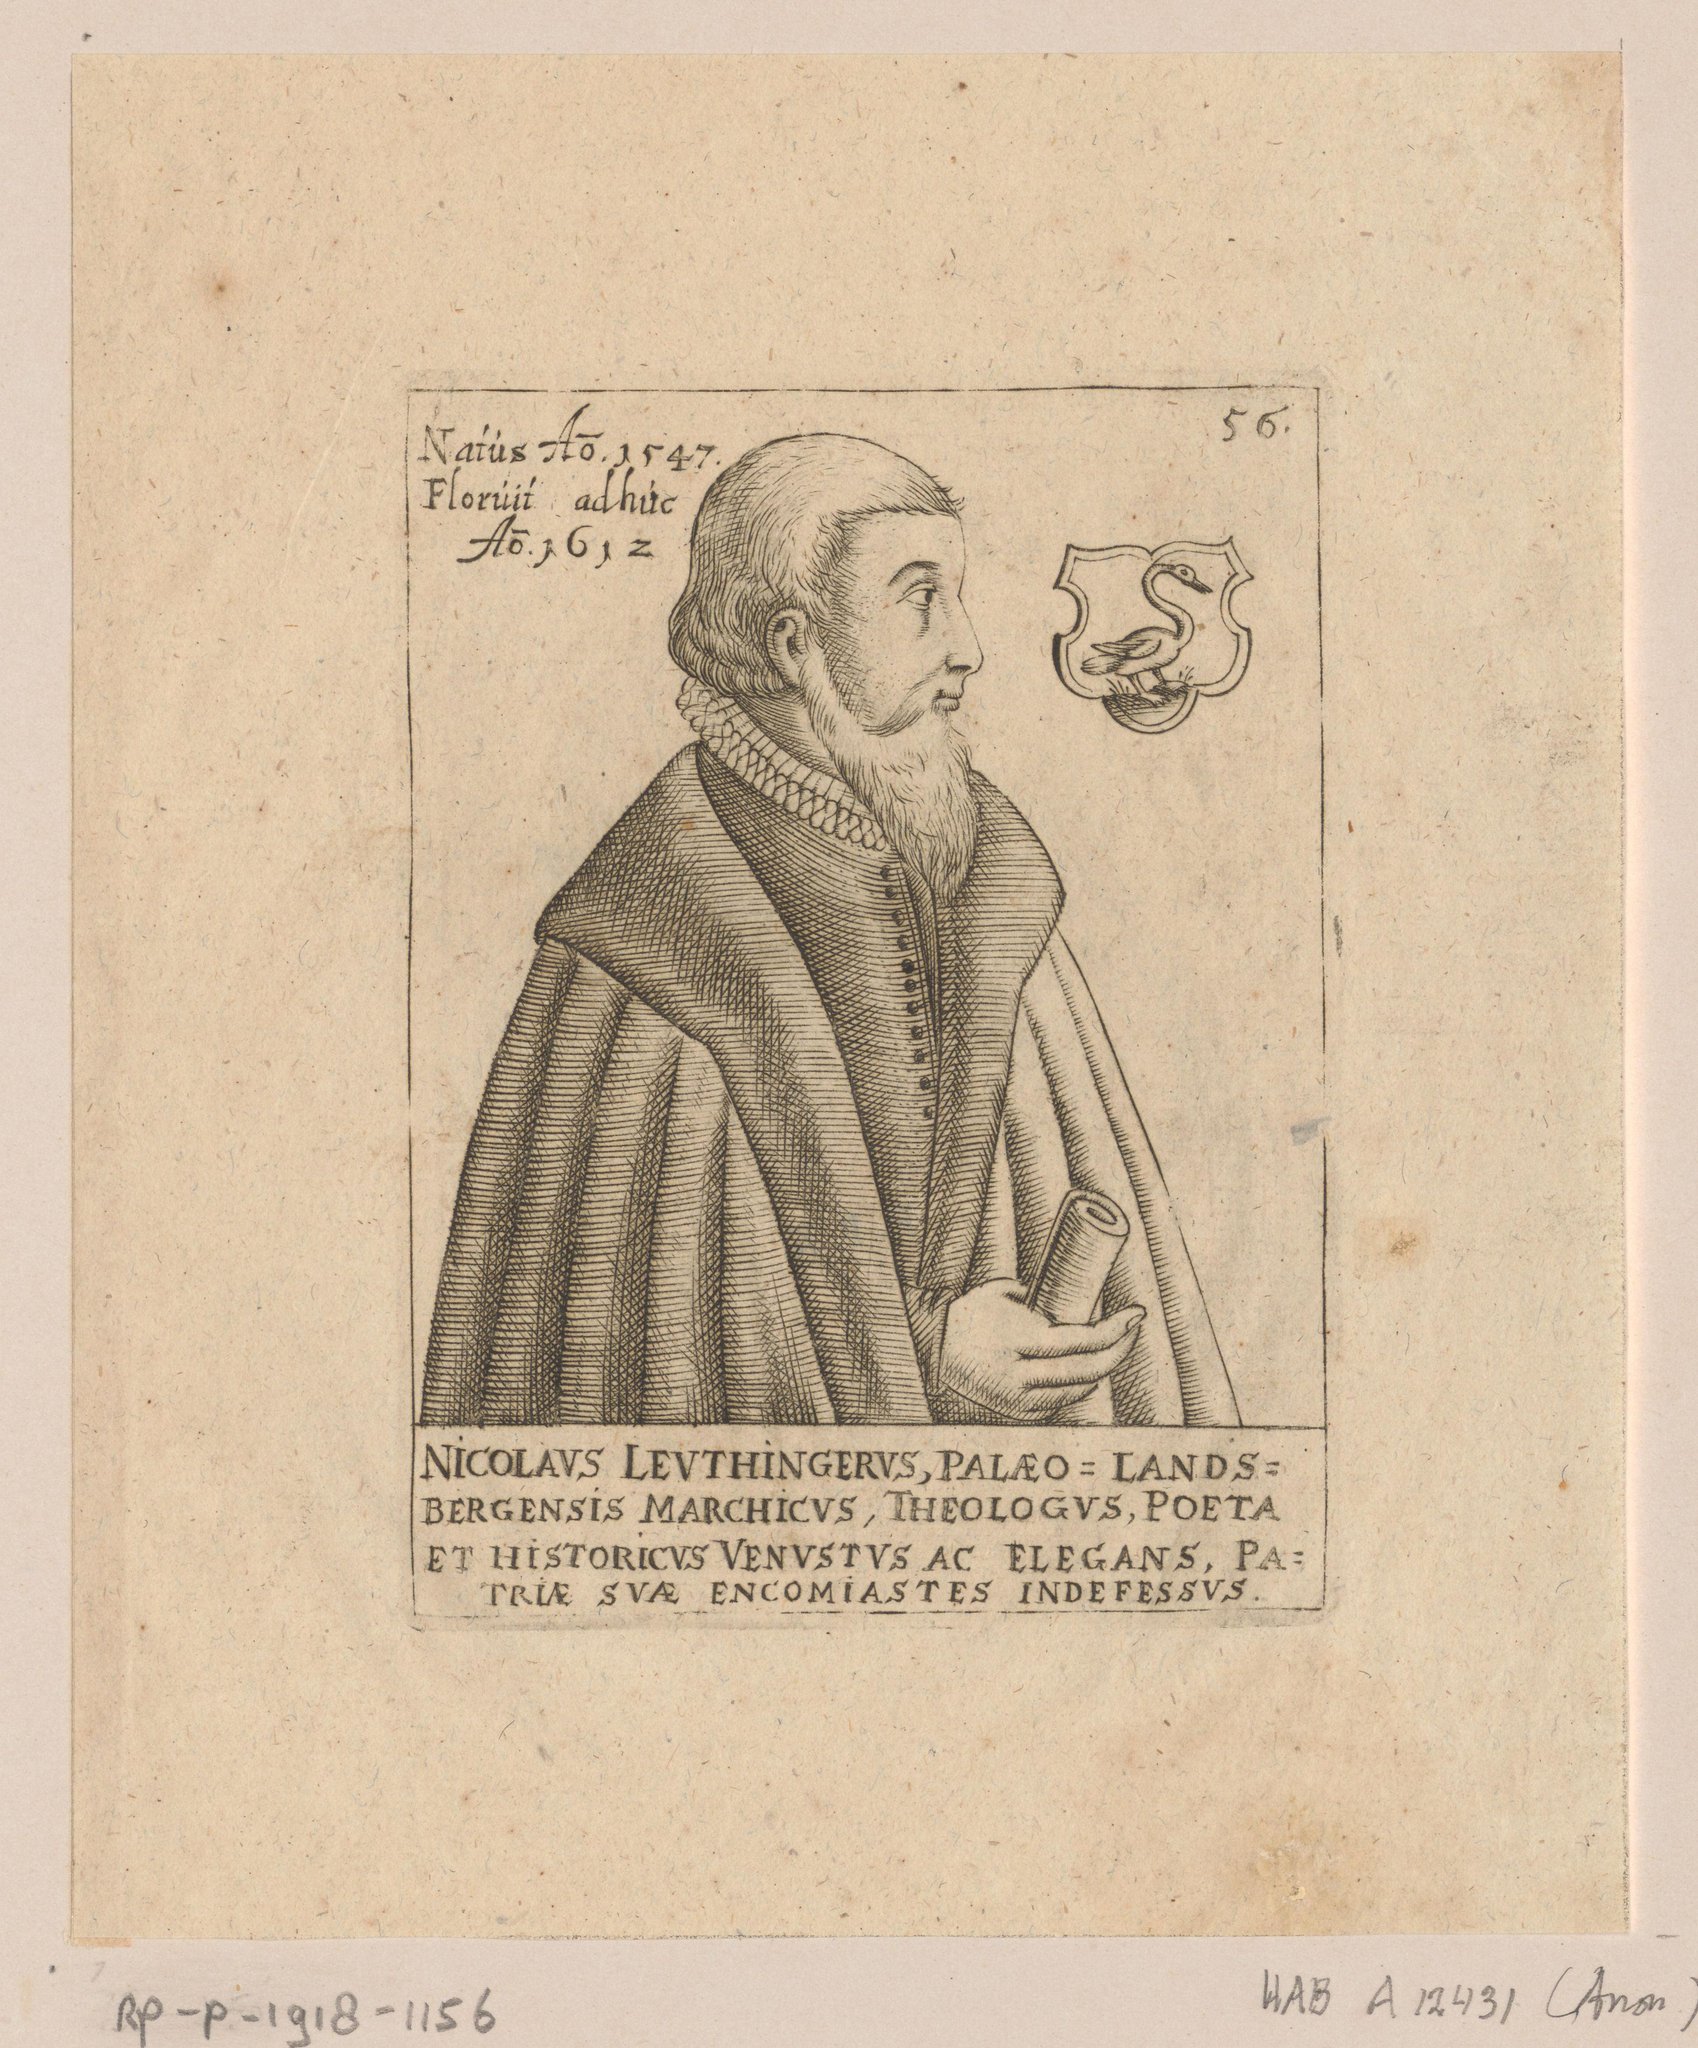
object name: print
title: Portret van Nicolaus Leutinger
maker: Anonymous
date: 1751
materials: paper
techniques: engraving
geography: germany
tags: theologian, historical persons, armorial bearing, heraldry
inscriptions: collector's mark: Lugt 2233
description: Prent waarschijnlijk uit: Küster, Georg Gottfried. Martin Friedrich Seidels Bilder-Sammlung in welcher hundert, gröstentheils in der Mark Brandenburg (…). Berlijn: Buchladen bey der Real-Schule, 1751. Kopie naar de prent uitgegeven door Andreas Luppius in 1717.